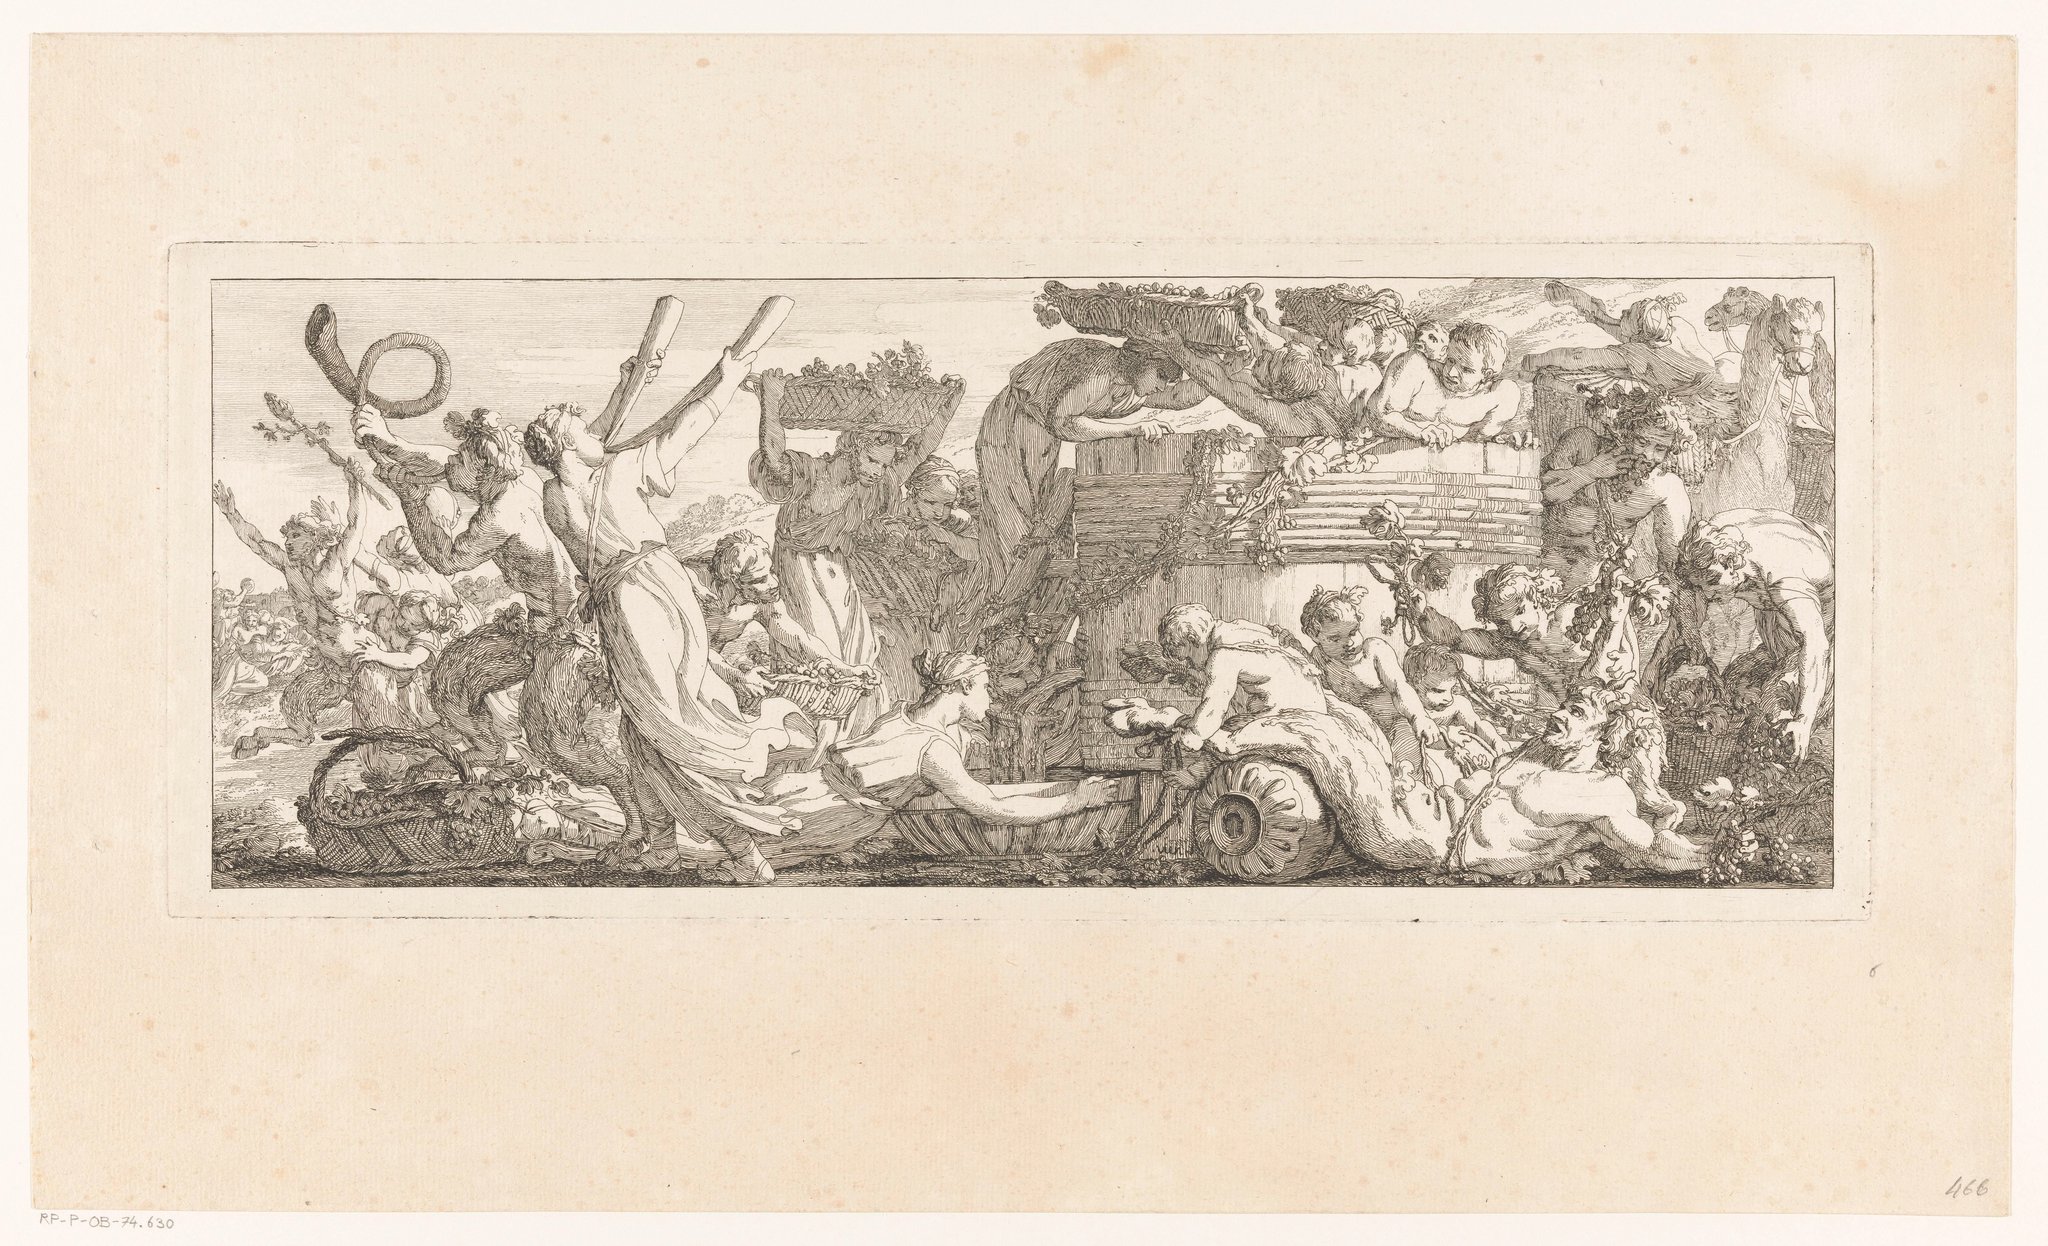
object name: print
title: Les travaux de la vendange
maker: joseph-marie vien (i)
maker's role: painter, print maker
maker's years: 1716-1809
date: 1750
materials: paper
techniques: etching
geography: rome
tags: wooden container: barrel, cask, bucket, maenad(s), female bacchant(es), male bacchant(es), satyr(s) (in general)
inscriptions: collector's mark: Lugt 240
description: Bacchantische scène in friesvorm met bacchanten en saters. Rechts van het midden staat een groot wijnvat waarheen manden met druiven worden gevoerd. Midden onder ligt een vrouw die wijn uit het vat in een schaal laat stromen, rechts van haar ligt een sater op de grond en links van haar wordt muziek gemaakt.